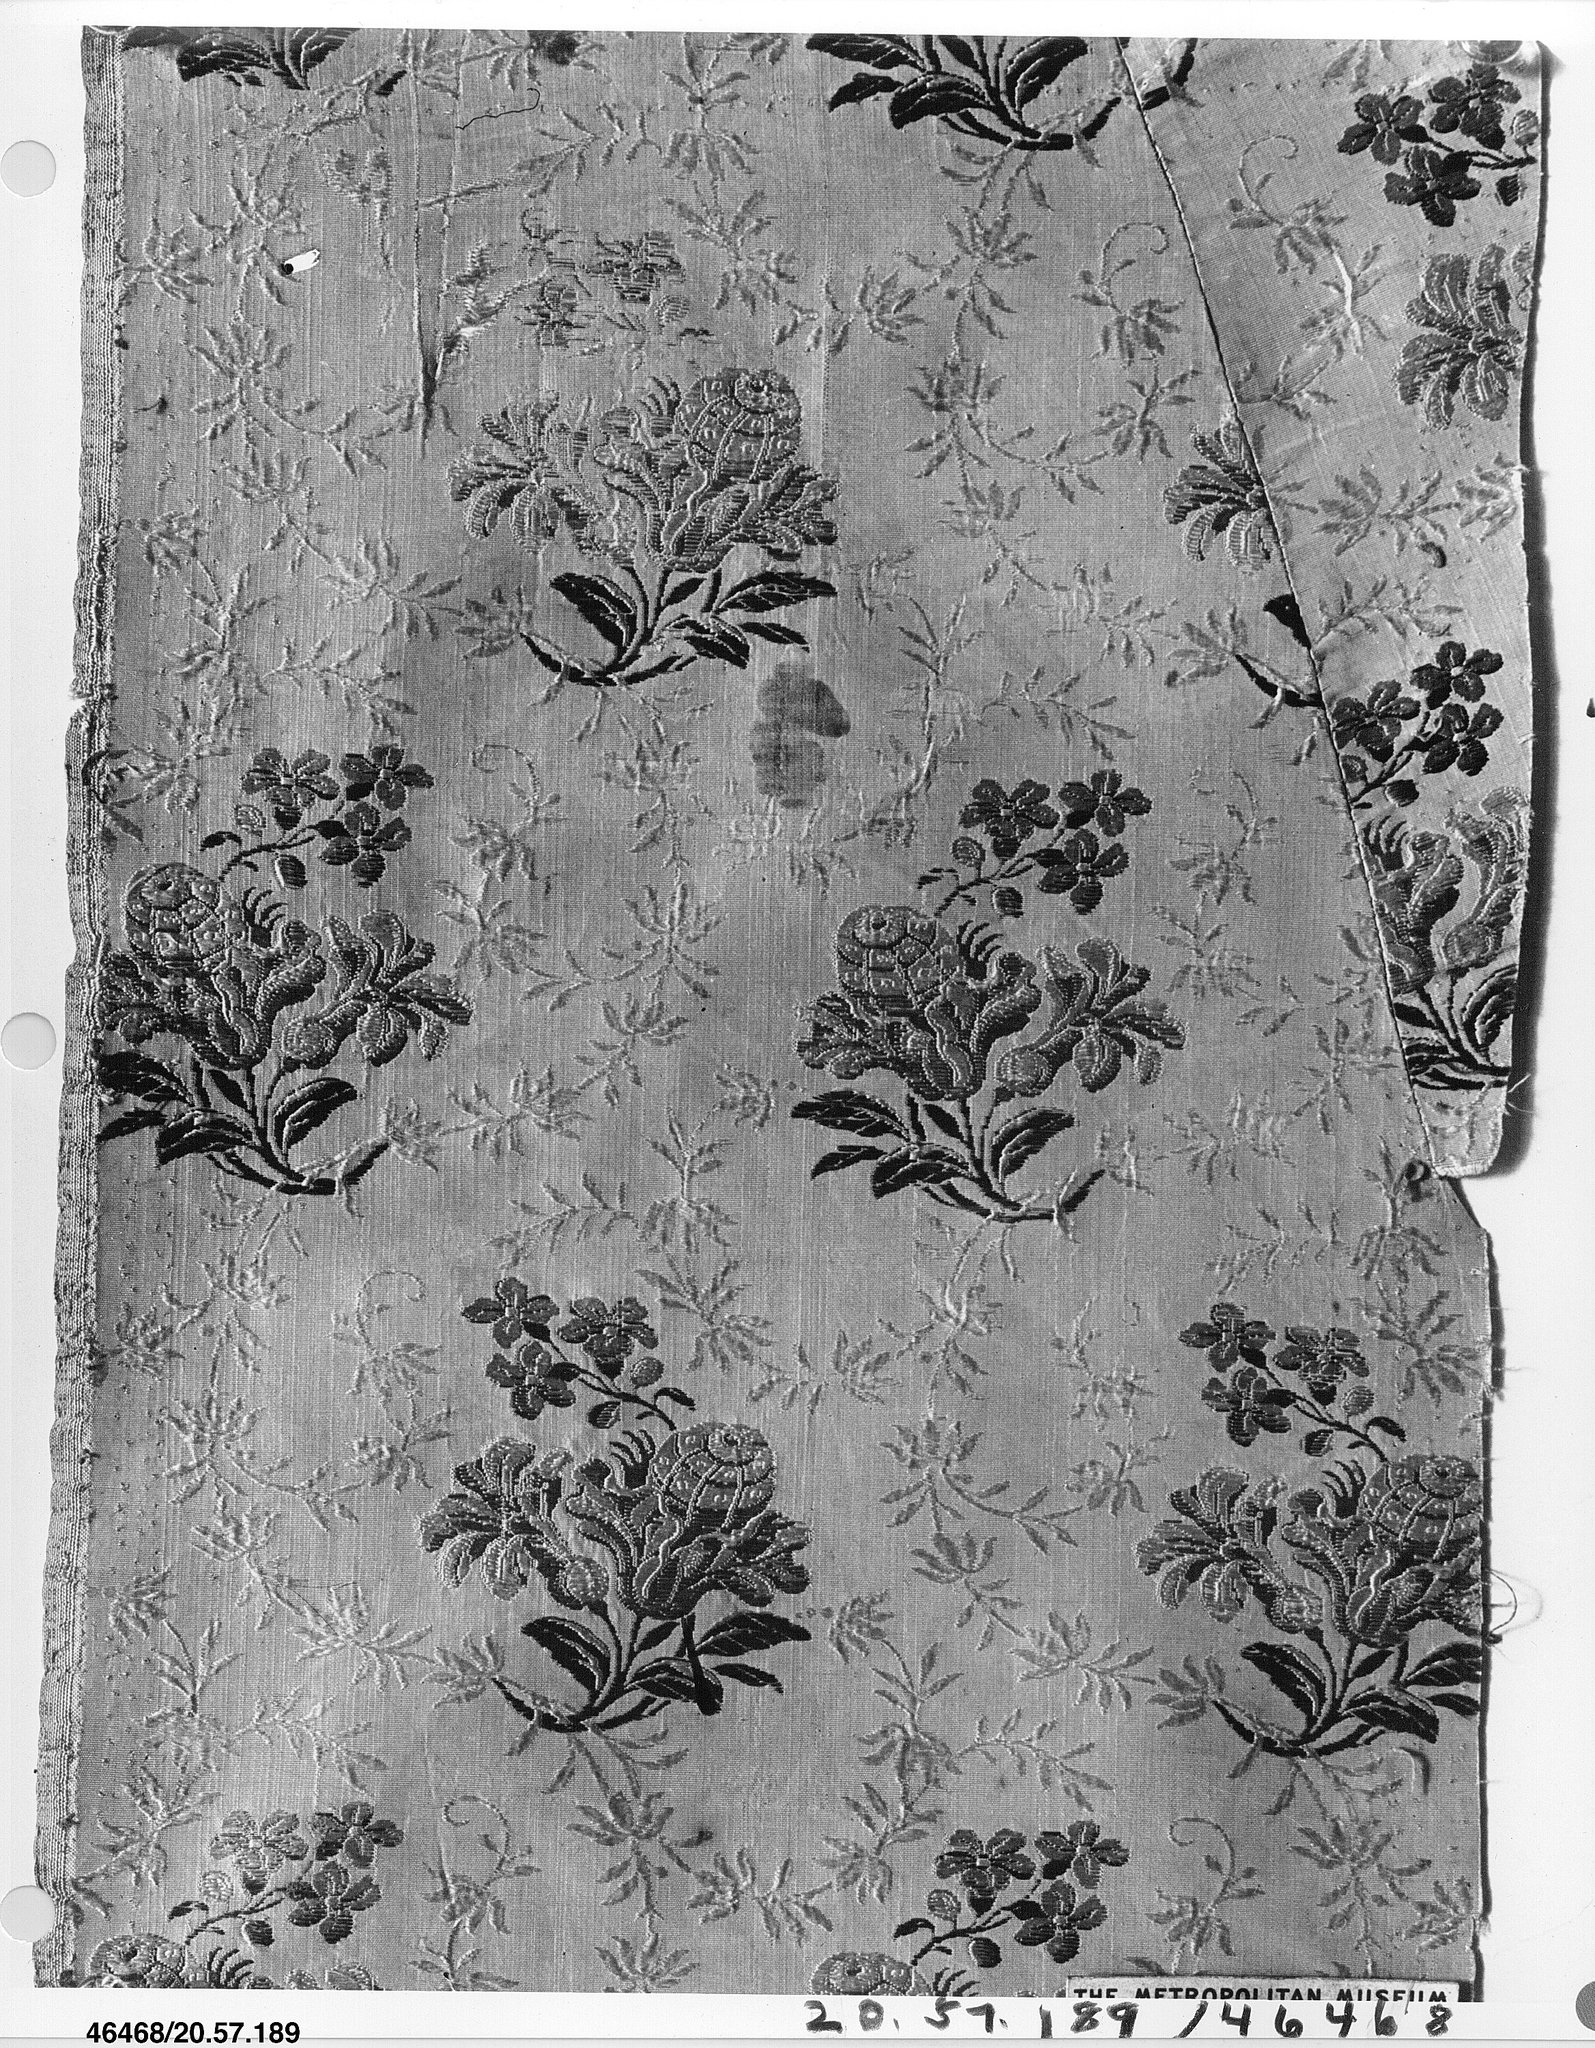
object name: piece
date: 1760-1770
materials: silk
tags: flowers,leaves